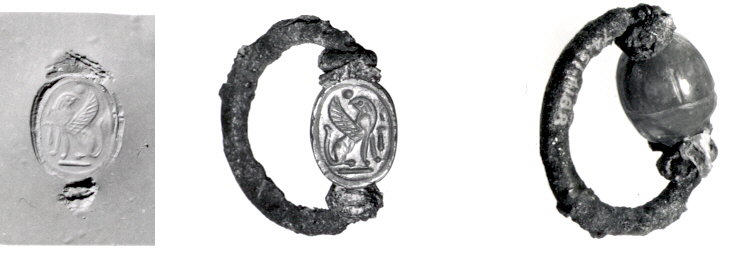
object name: ring with scarab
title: Silver swivel ring with sard scarab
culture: cypriot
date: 800-668 BCE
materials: silver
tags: sphinx,scarabs